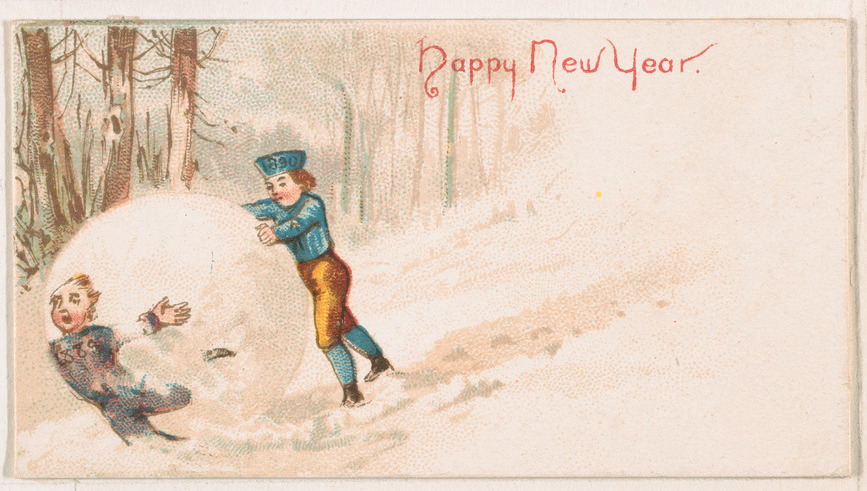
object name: print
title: Happy New Year, from the New Years 1890 series (N227) issued by Kinney Bros.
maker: kinney brothers tobacco company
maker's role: publisher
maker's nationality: american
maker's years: 1869-2011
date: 1889-1890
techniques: color lithograph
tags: boys,playing,snow